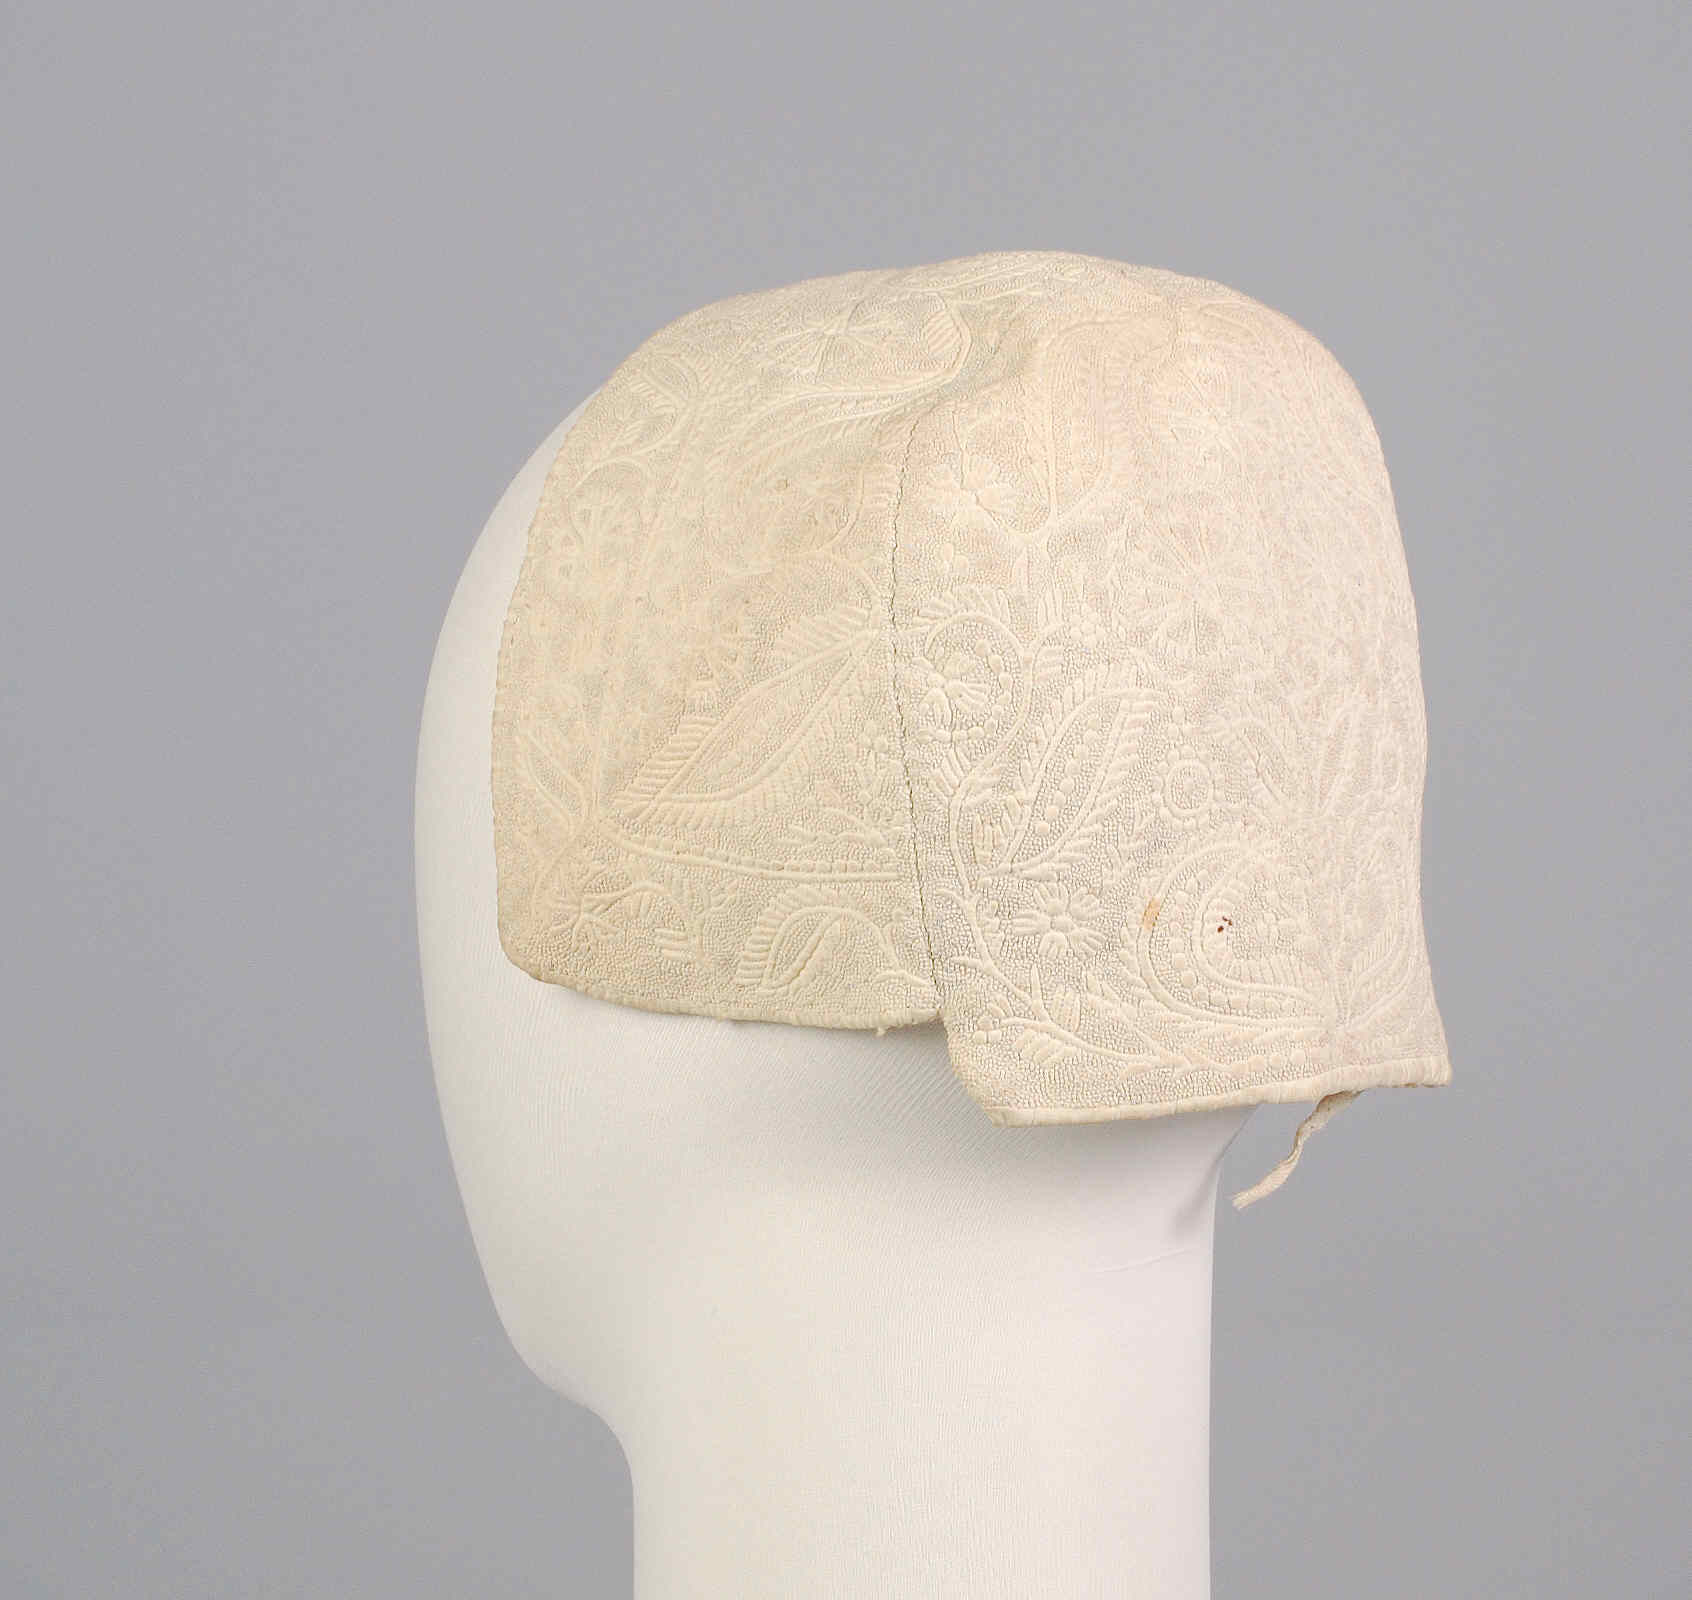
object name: cap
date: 1830-1850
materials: linen